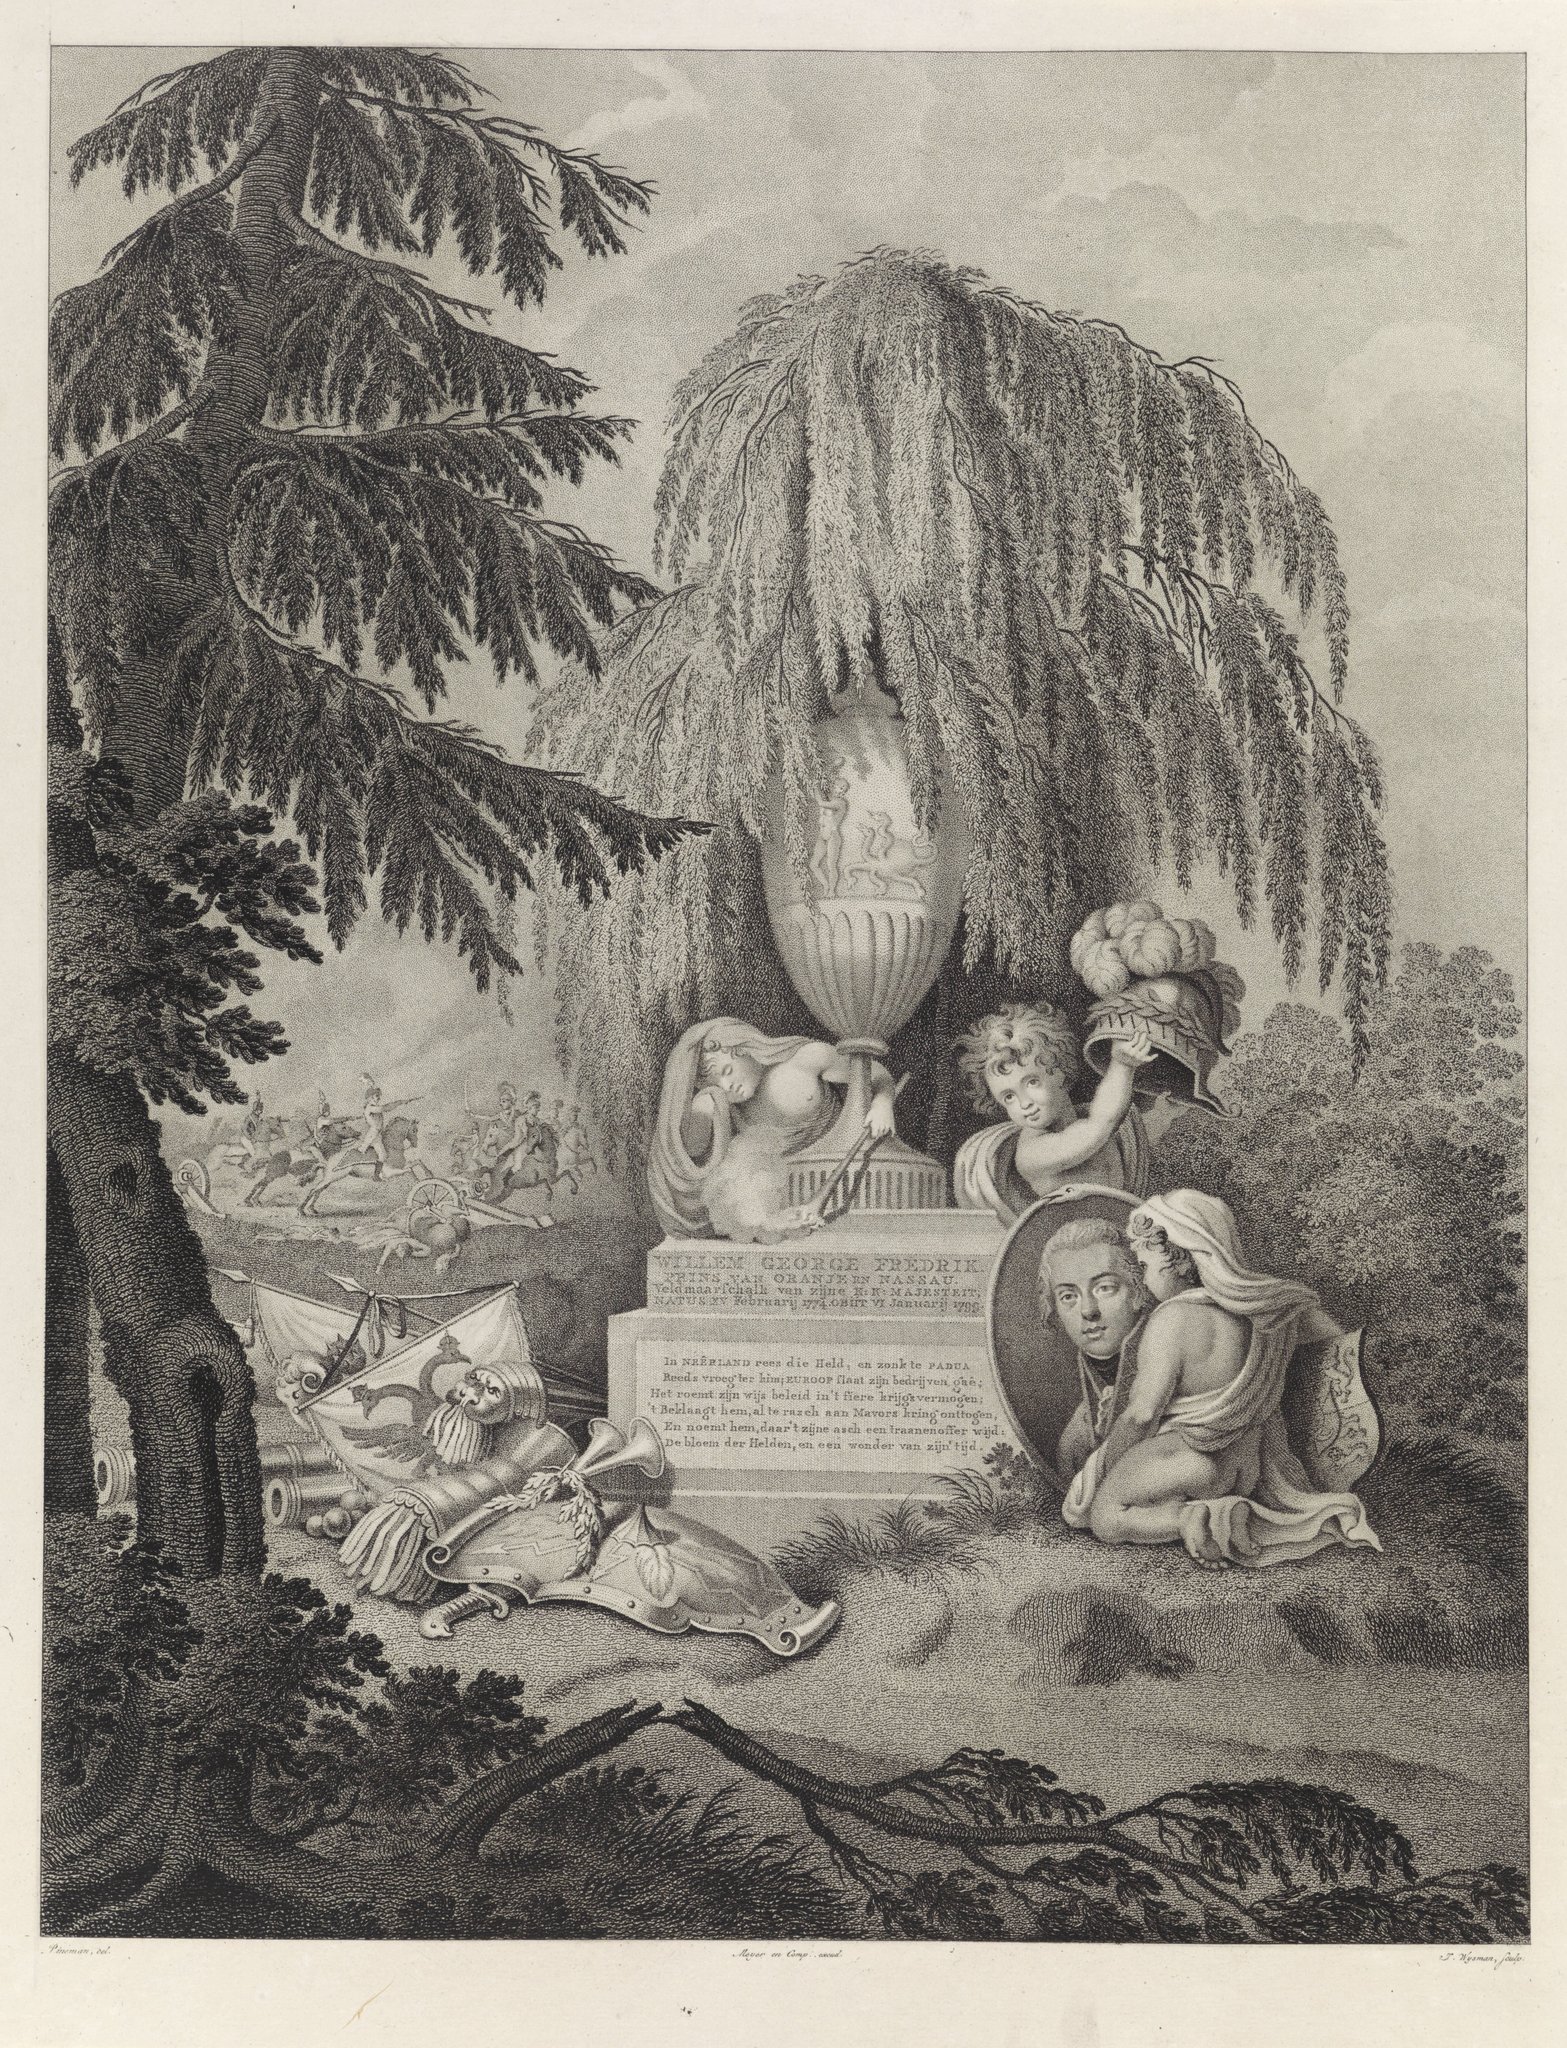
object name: print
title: Allegorisch gedenkteken voor prins Frederik, 1799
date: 1799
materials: paper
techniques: stippled etching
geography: netherlands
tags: willem george frederik (prins van oranje-nassau), grave-building, monumental tomb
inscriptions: collector's mark: Lugt 2228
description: Allegorisch gedenkteken voor Willem George Frederik, prins van Oranje-Nassau, overleden te Padua, 6 januari 1799. Monument met urn overschaduwd door een treurwilg, putti met gedoofde toorts, helm en portret. Op het voetstuk een zesregelig vers. Op de grond voor het monument een wapenrusting en vaandels, op de achtergrond een ruitergevecht.